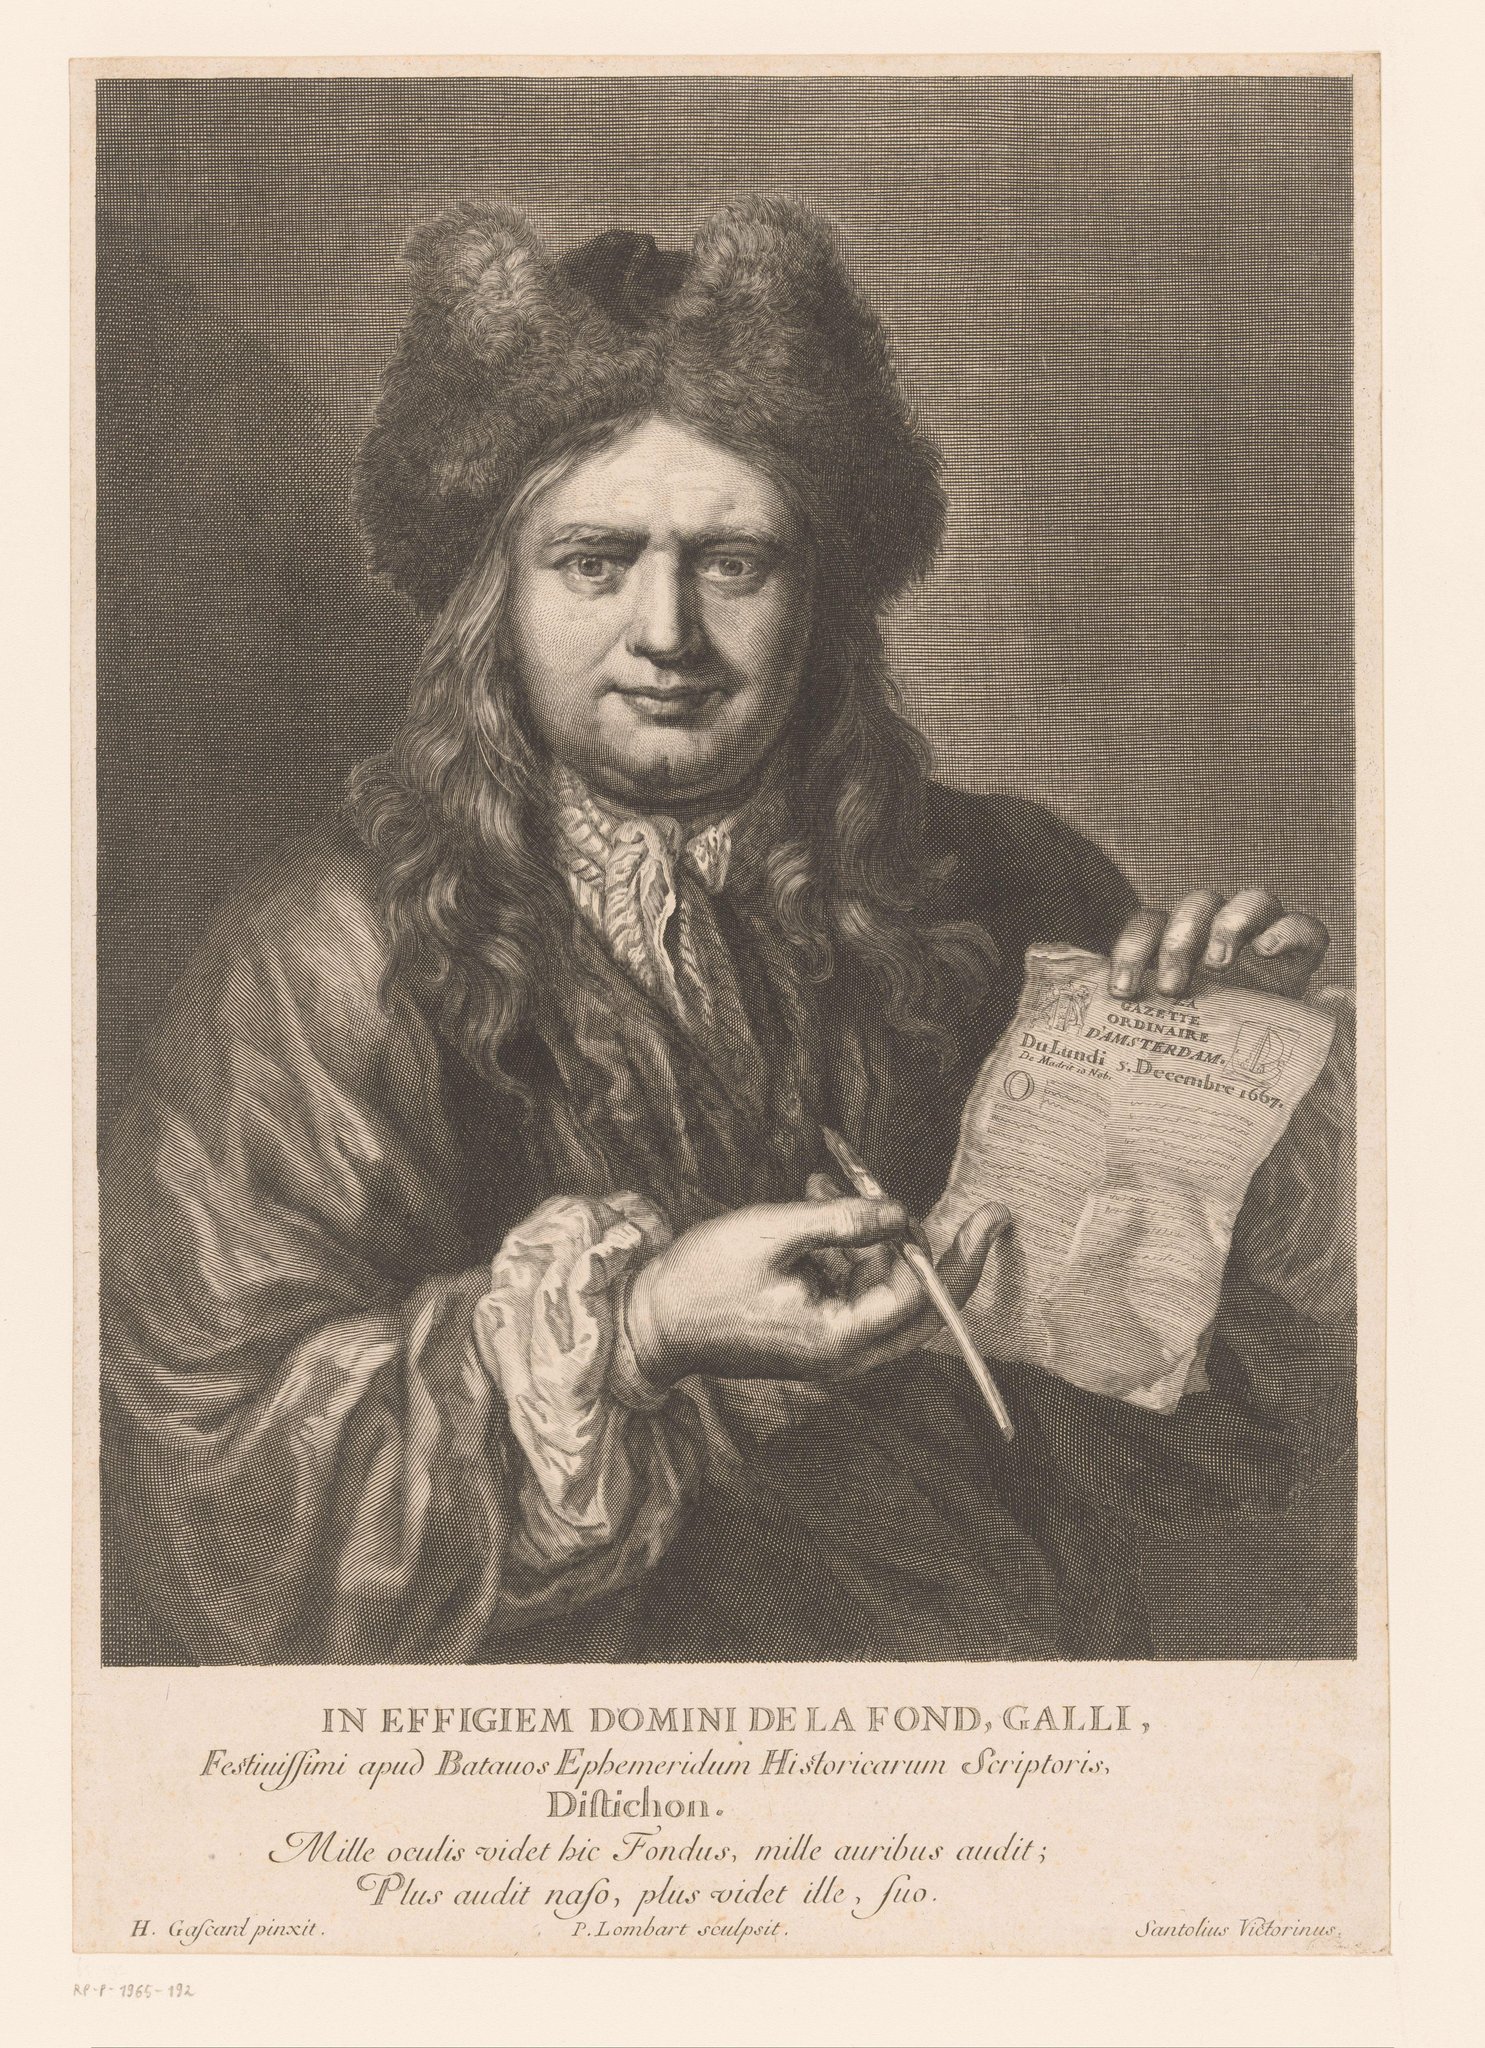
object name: print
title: Portret van Jean-Alexandre de la Font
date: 1667-1682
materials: paper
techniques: engraving, etching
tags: publisher, historical persons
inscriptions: collector's mark: Lugt 2228, collector's mark: Lugt 2760